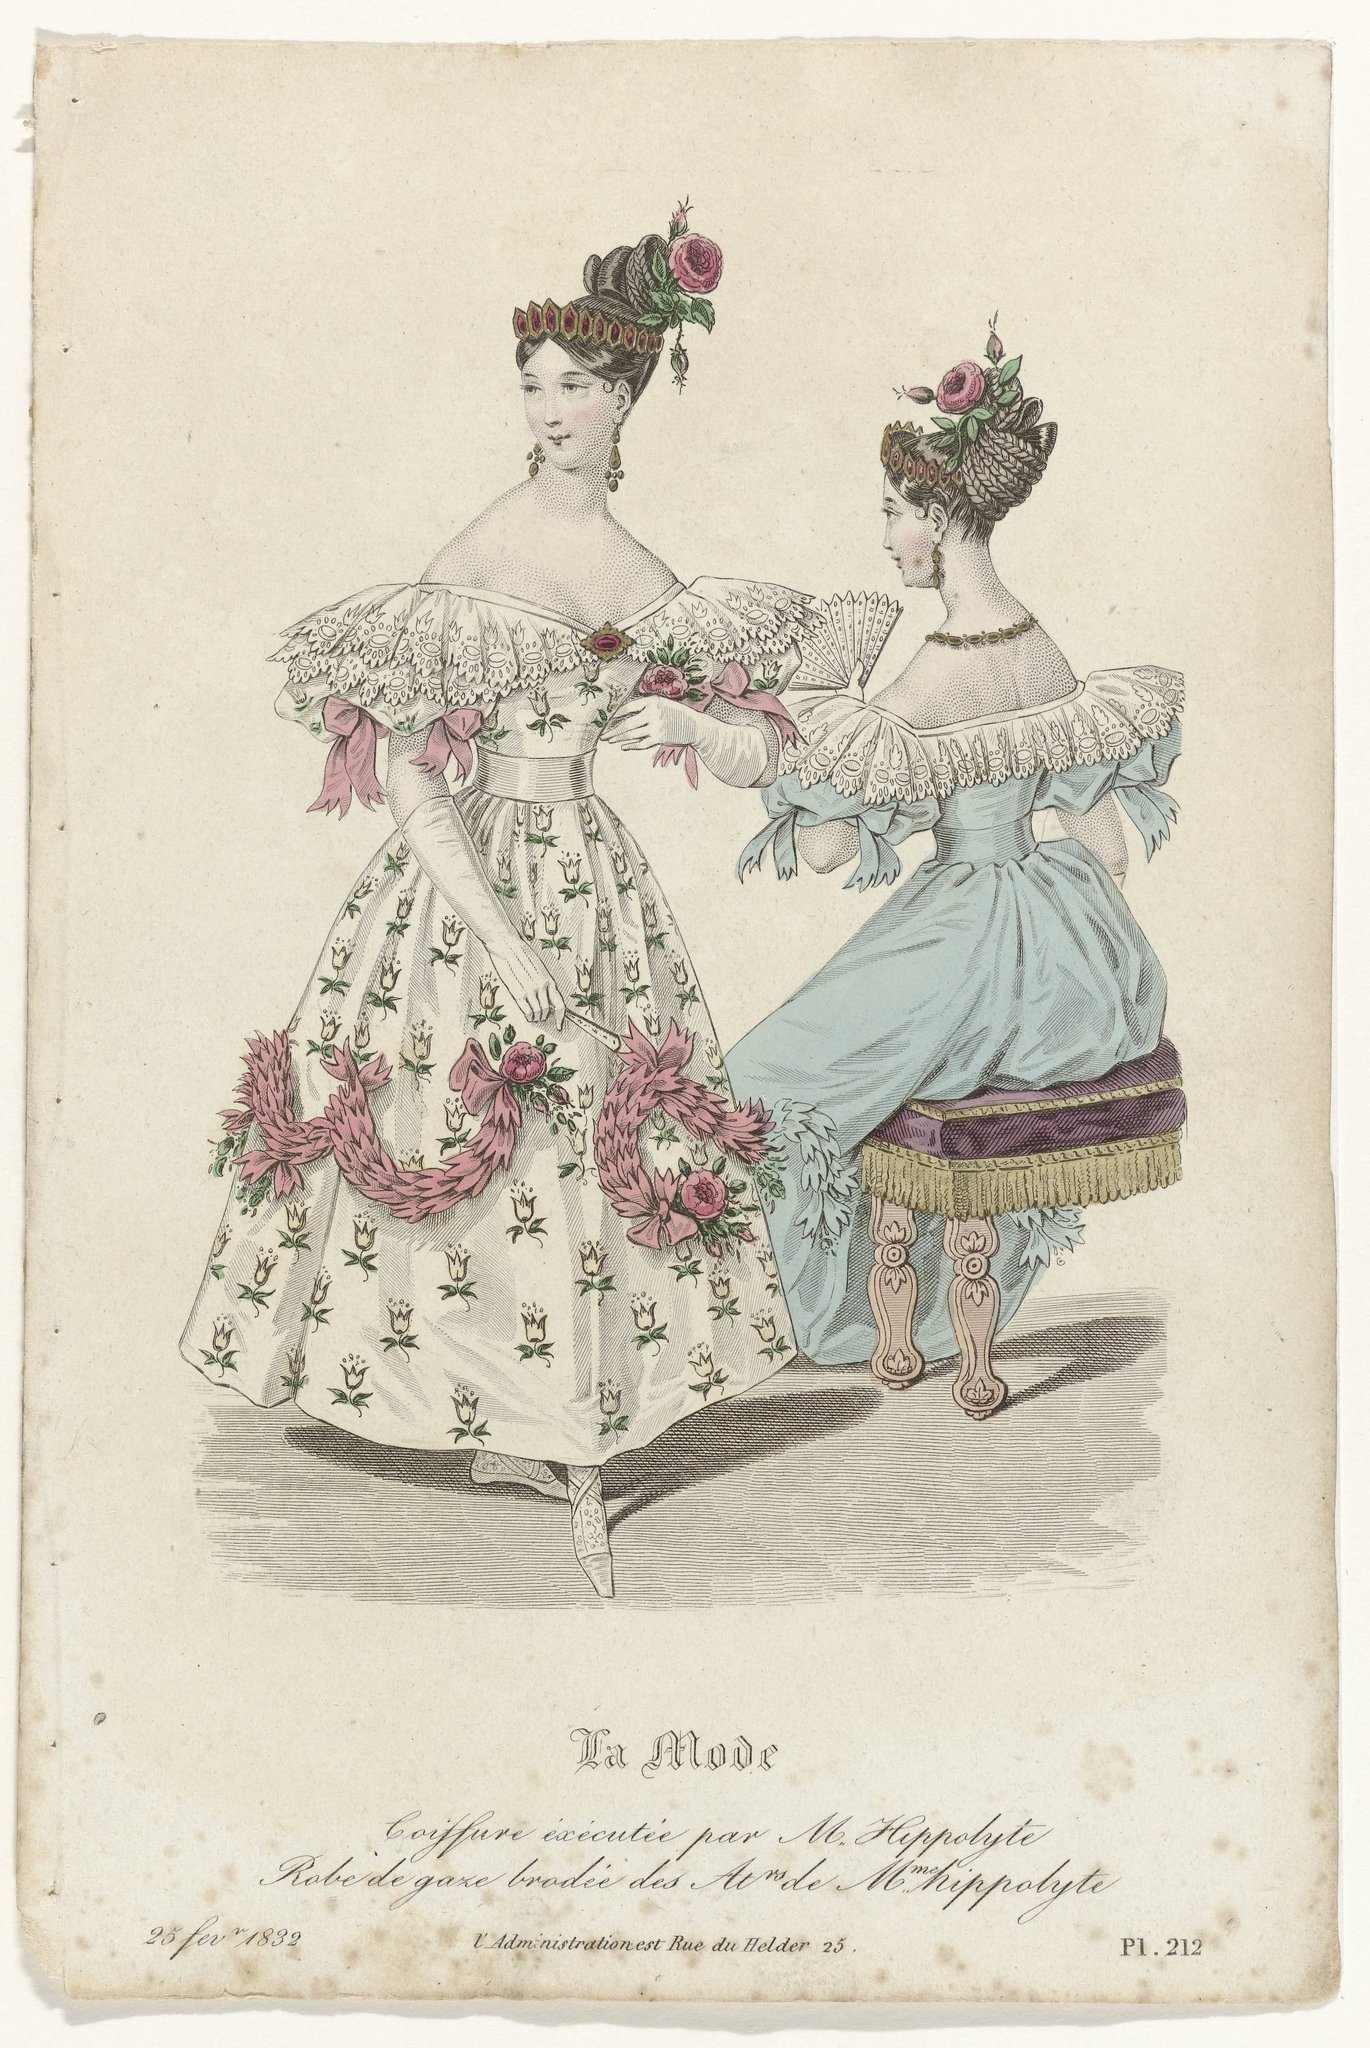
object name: fashion print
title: La Mode, 25 fevrier 1832, Pl. 212 : Coiffure éxécuté (...)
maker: Anonymous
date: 1832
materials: paper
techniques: engraving, hand coloring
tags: clothing for the upper part of the body (+ women's clothes), brooch, agraffe, clasp (+ women's clothes), diadem, tiara (+ women's clothes), dress, gown: evening dress (+ women's clothes), gloves, mittens (long gloves) (+ women's clothes), embroidery (ornamentation) (+ women's clothes), styles of hairdress - aa - ~ women, fashion plates, flowers: rose, necklace (+ women's clothes)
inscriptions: address: ‘L'Administration est Rue du Helder 25.’, caption: ‘Coiffure éxécutée par M Hippolyte Robe de gaze brodée des At.rs de Mme Hippolyte’, title: ‘La Mode’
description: Coiffure uitgevoerd door M Hippolyrte. Japon van geborduurde tule met bloemmotief van het atelier van Hippolyte. Accessoires: diadeem, oorbellen, collier, broche, lange handschoenen, briséwaaier, schoenen met gekruiste banden en vierkante neuzen. Prent uit het modetijdschrift La Mode (1829-1855).